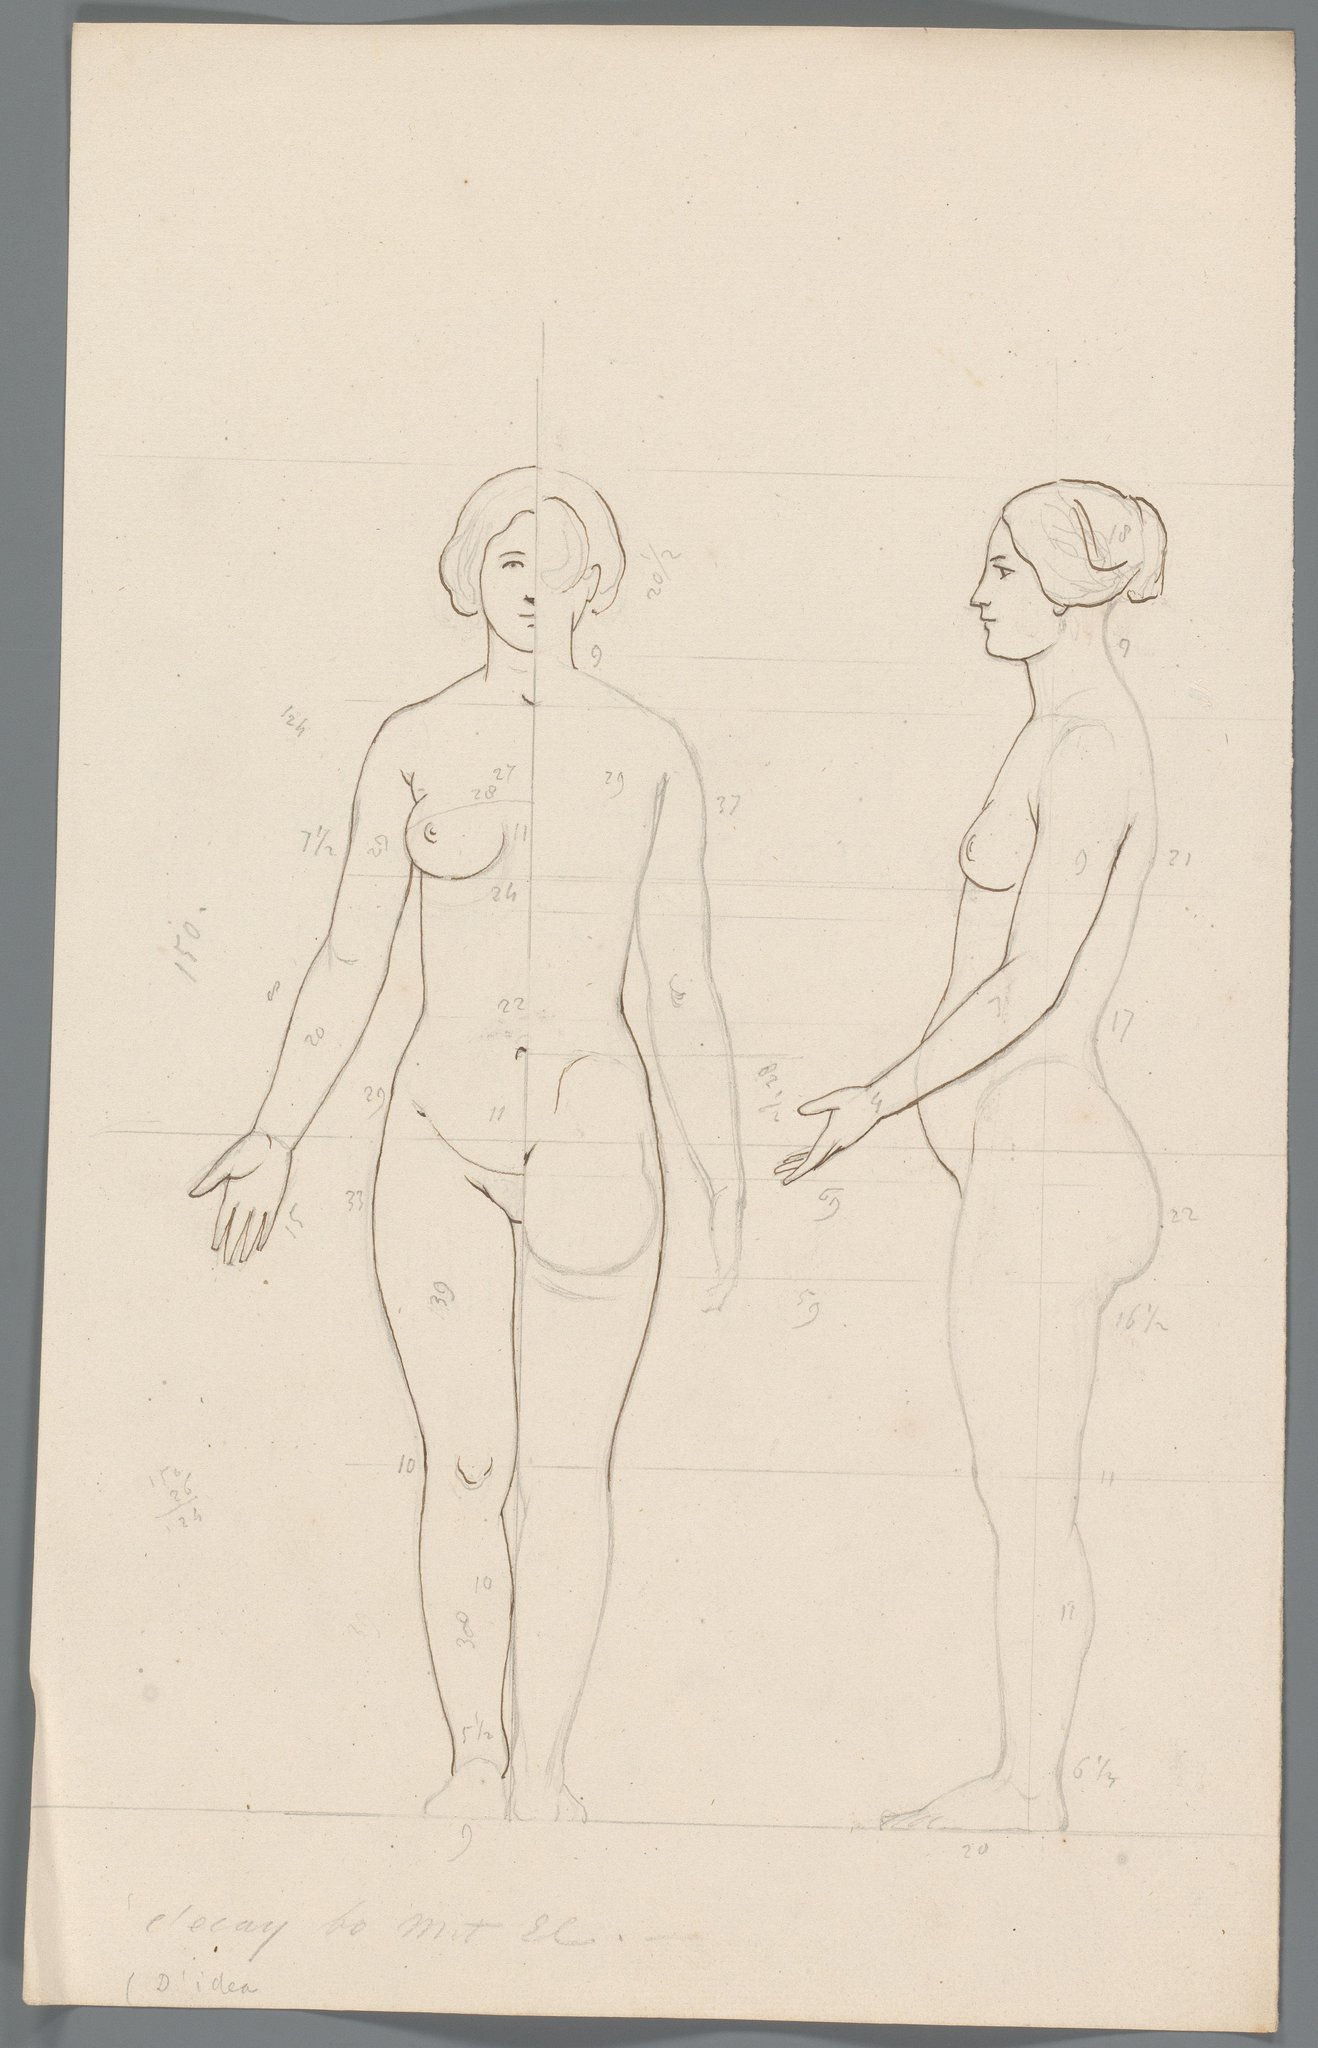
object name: drawing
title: Proportiestudie van een vrouw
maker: jacobus everhardus josephus van den berg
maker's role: draughtsman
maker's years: 1802-1861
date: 1853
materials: paper, pencil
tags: standing figure (canon, proportions) - aa - female human figure, anatomy (non-medical) - aa - female human figure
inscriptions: inscription: ‘c'ecay bo mit EC/ (D'idea’